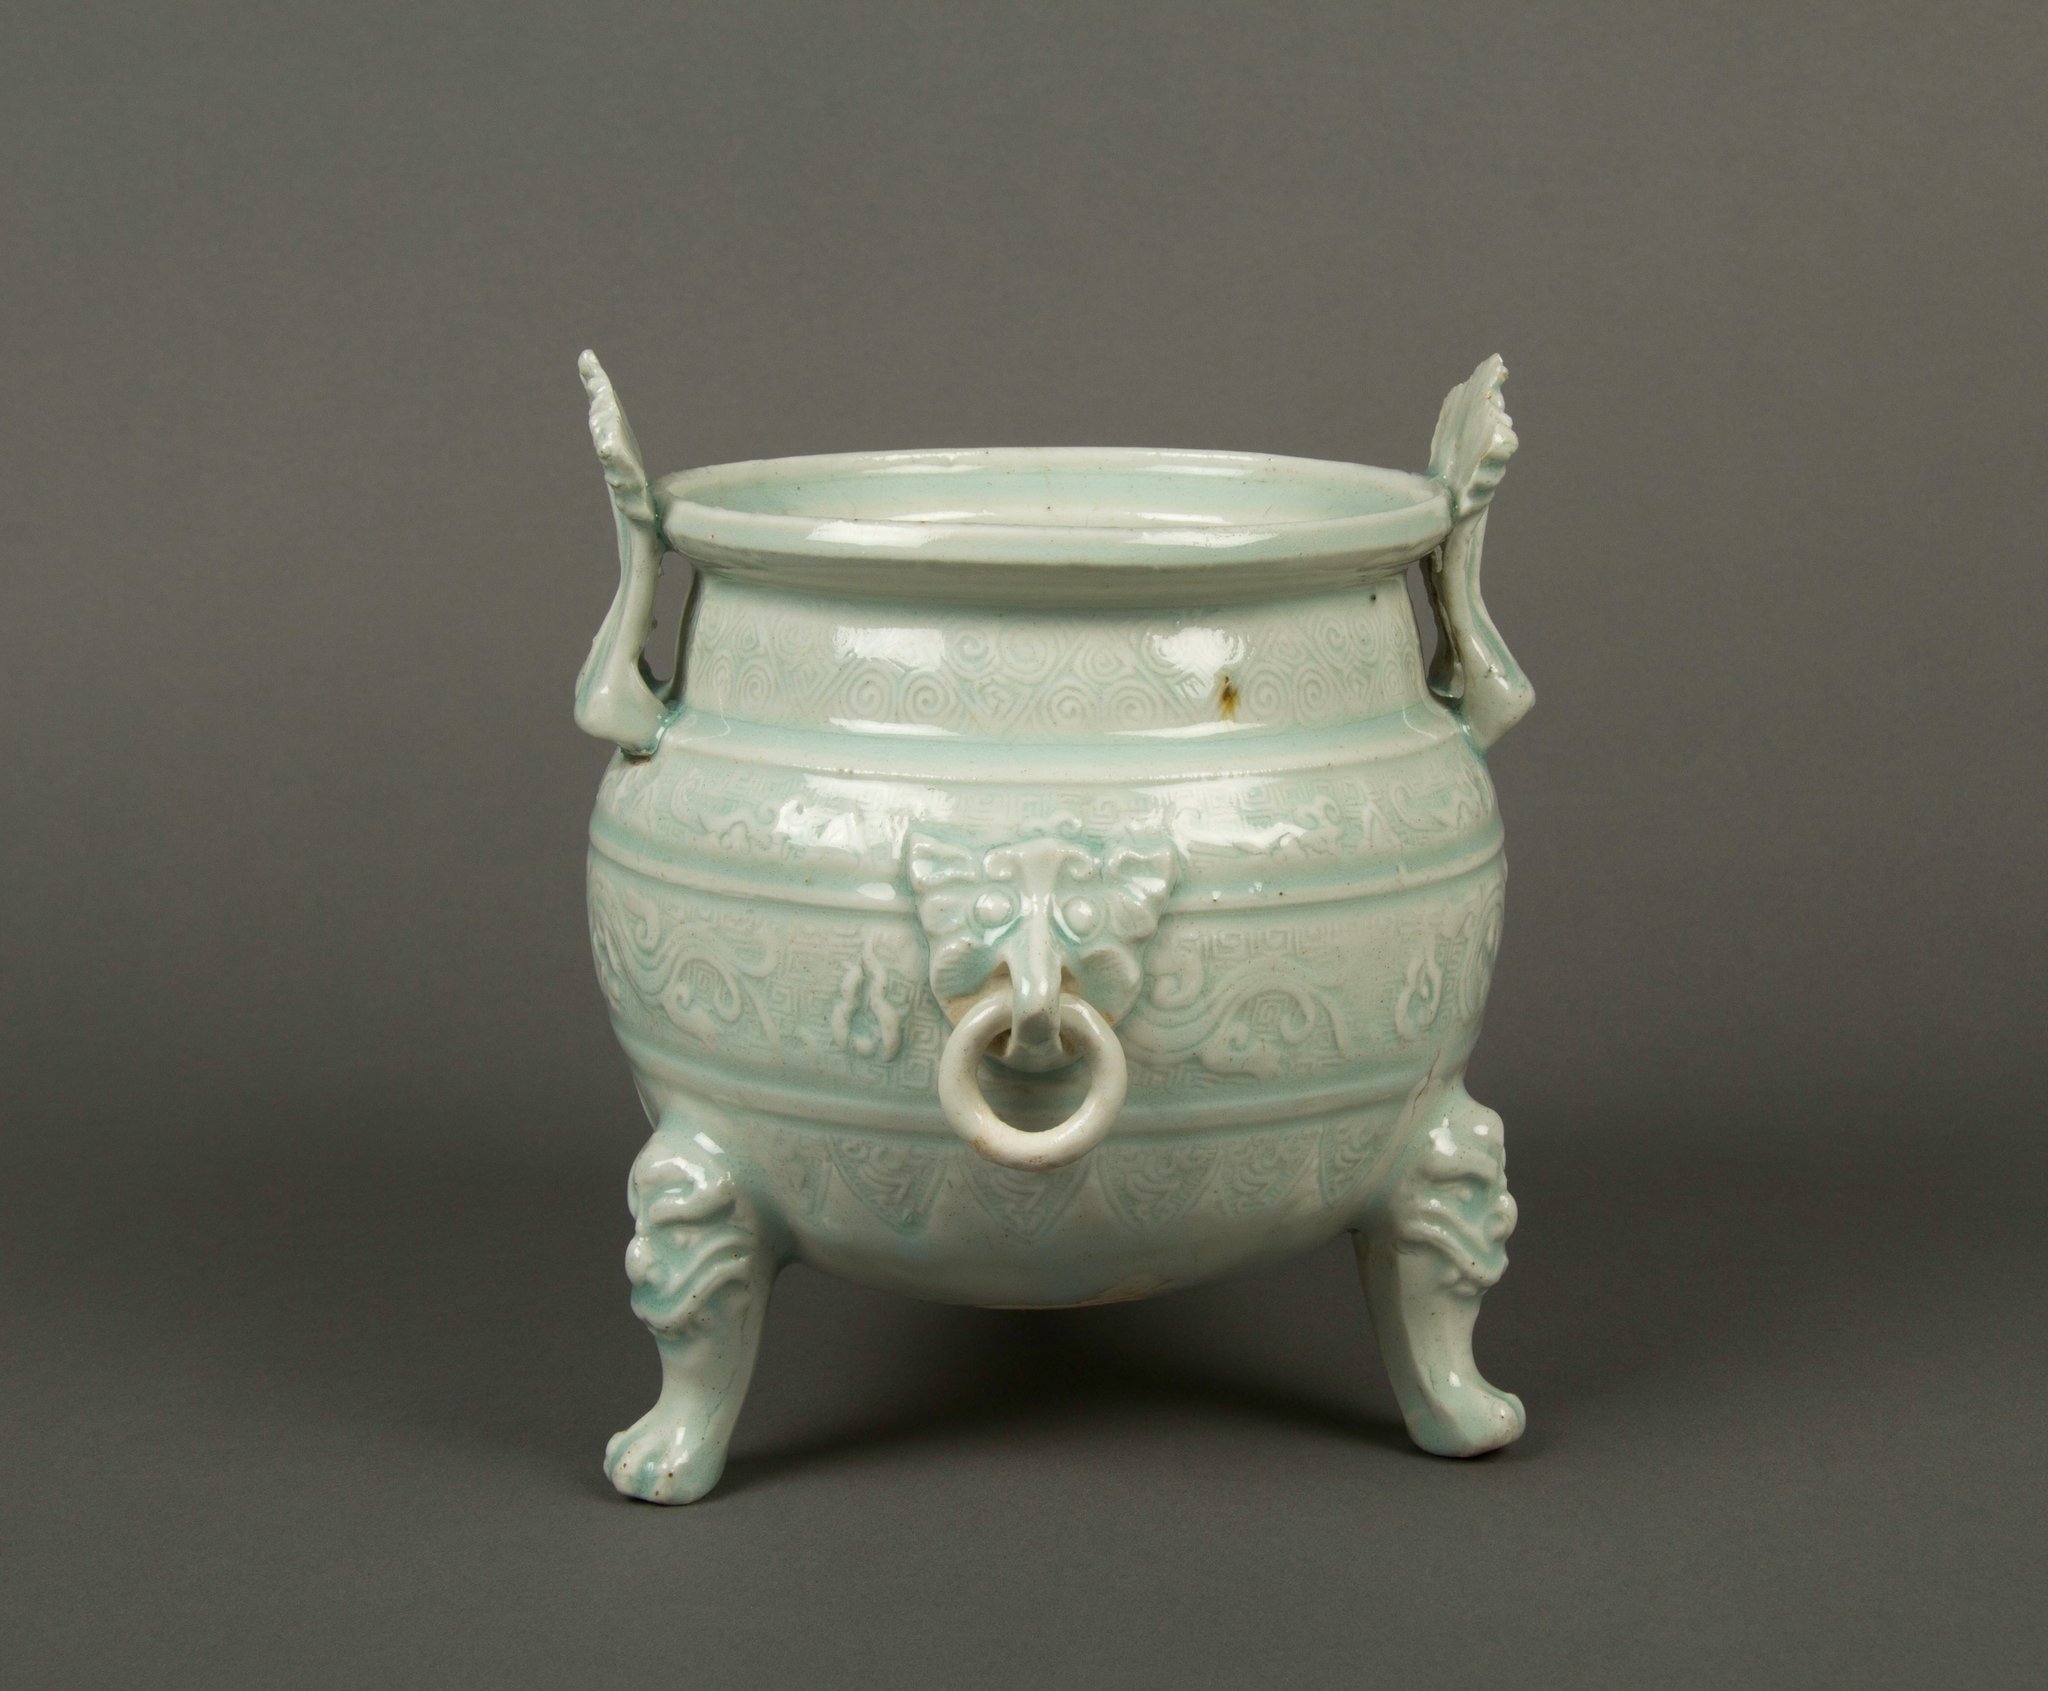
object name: incense burner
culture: chinese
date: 1201-1300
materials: glaze, porcelain